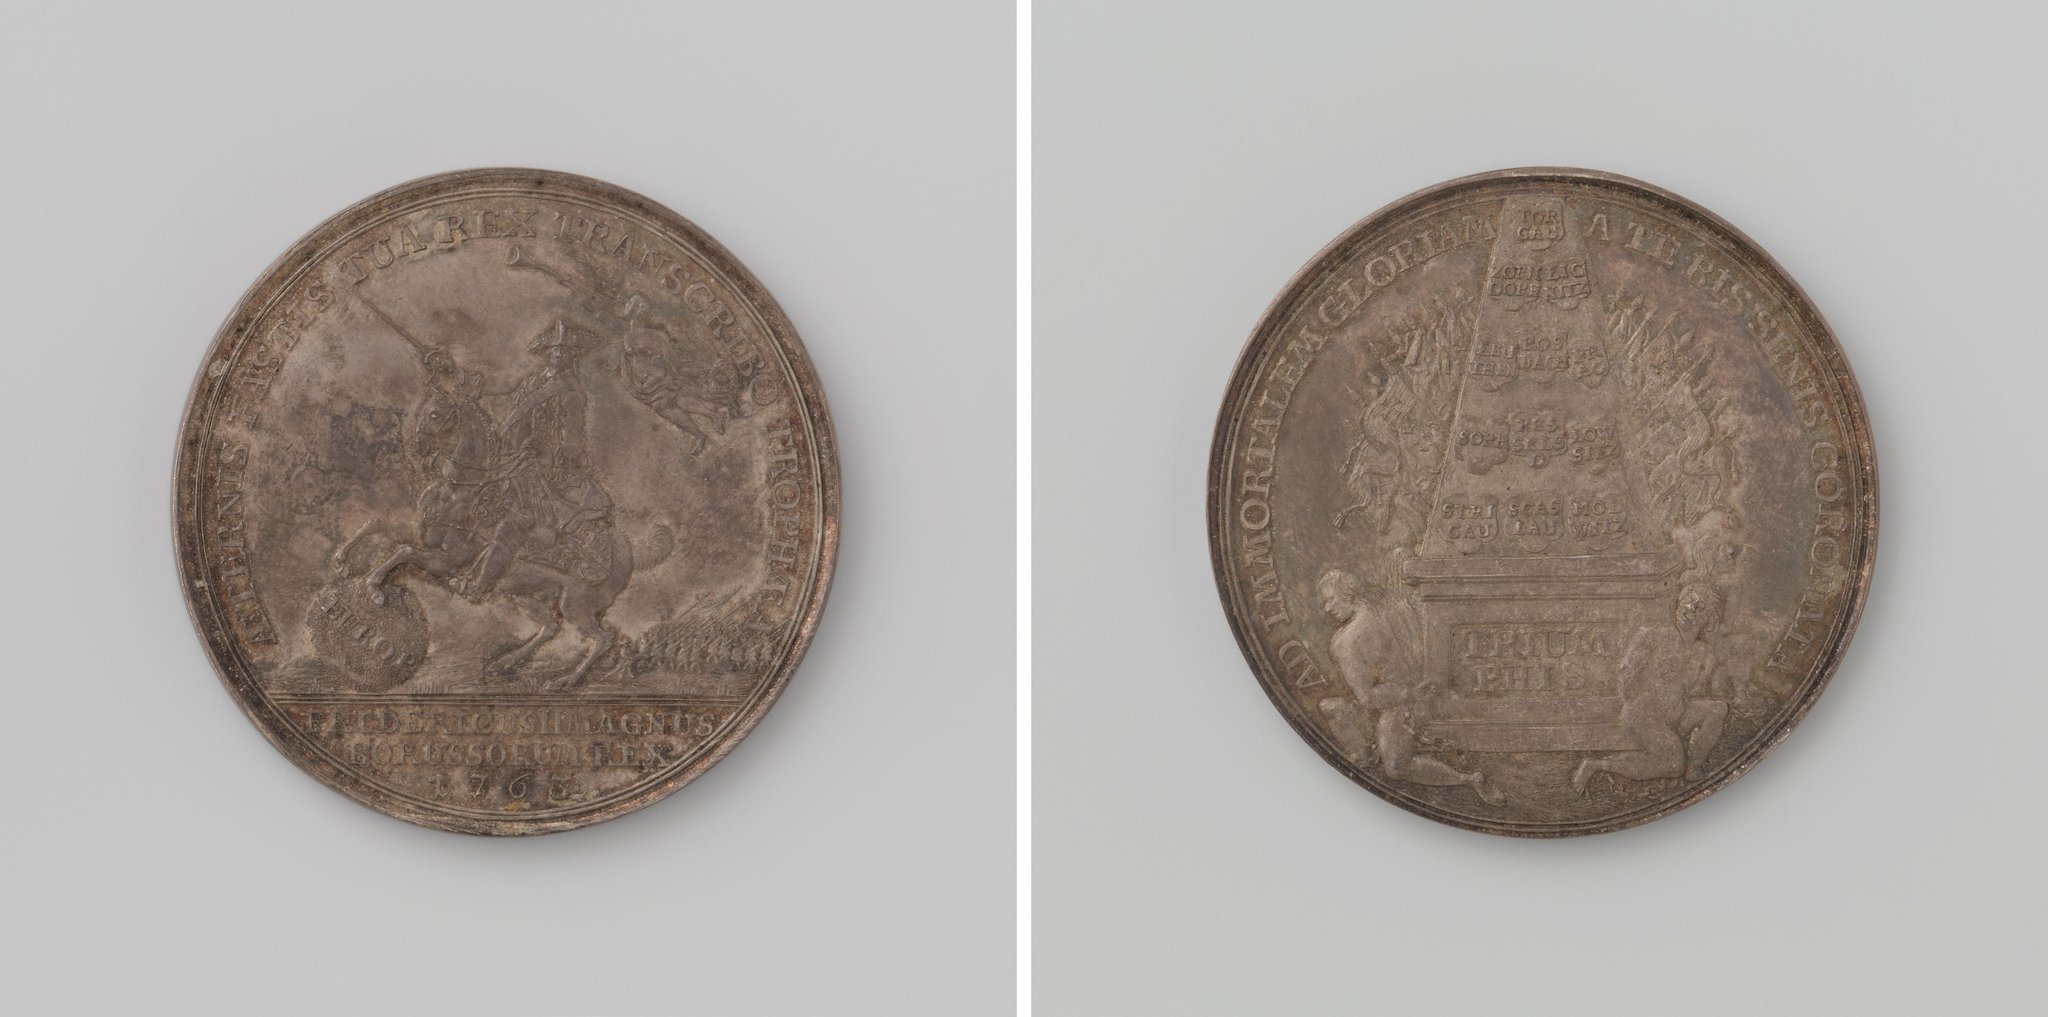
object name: history medal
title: Overwinningen van Frederik II de Grote, koning van Pruisen op de Oostenrijkers in de Oostenrijkse successieoorlog en de zevenjarige oorlog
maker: Anonymous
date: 1763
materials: silver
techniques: striking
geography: germany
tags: berlin, frederick ii (king of prussia), prague